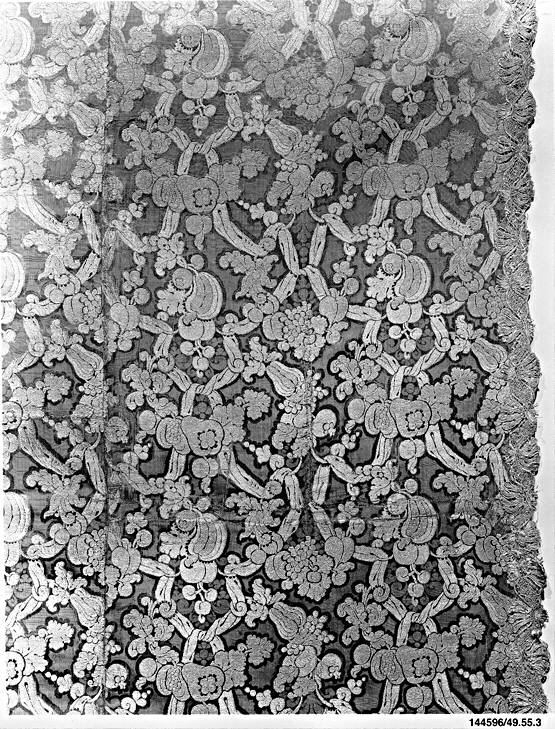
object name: piece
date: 1700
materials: metal thread, silk